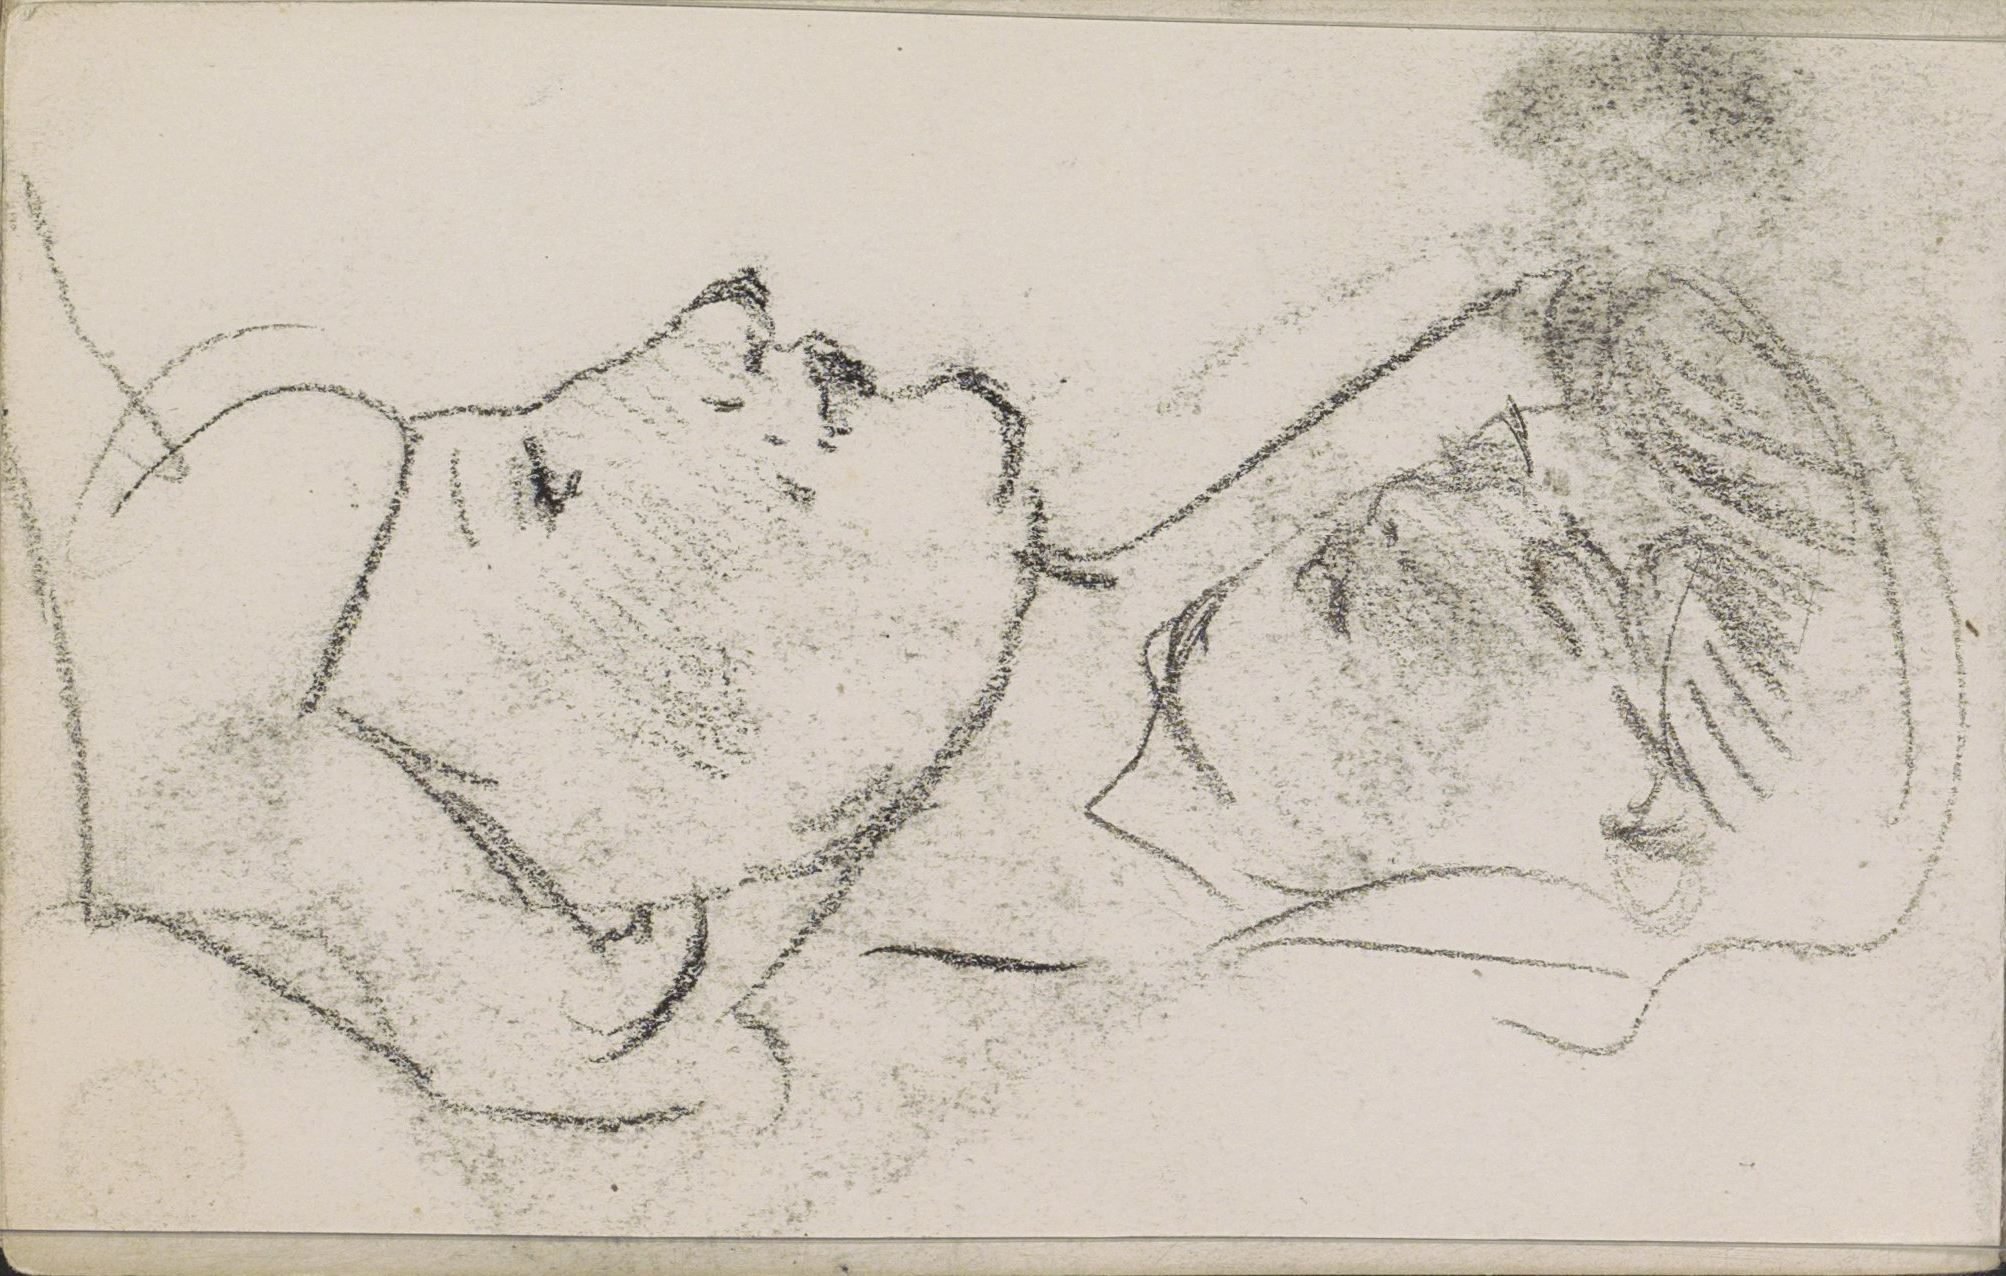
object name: sketchbook leaf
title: Twee vrouwenhoofden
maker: isaac israels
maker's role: draughtsman, painter, print maker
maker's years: 1865-1934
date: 1887-1934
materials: chalk, paper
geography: paris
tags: eyes closed, head (human) - aa - female human figure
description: Een vrouw met gesloten ogen en een vrouwenhoofd, in profiel. Pagina 31 uit schetsboek XLIX met 32 pagina's.